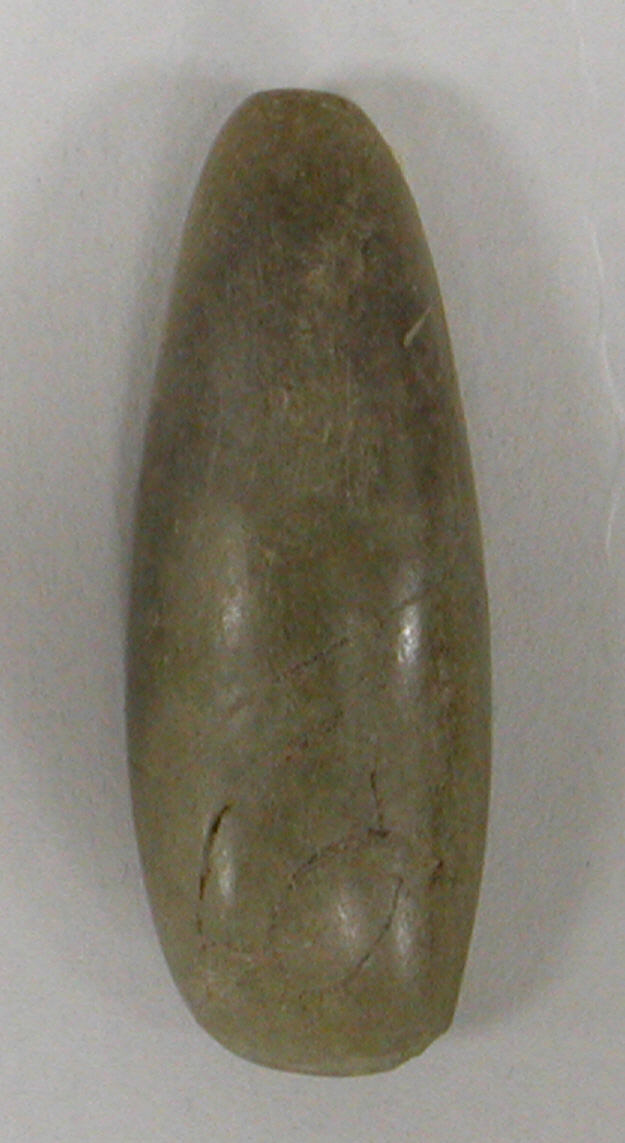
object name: chisel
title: Stone Chisel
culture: costa rican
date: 1501-1600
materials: stone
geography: costa rica